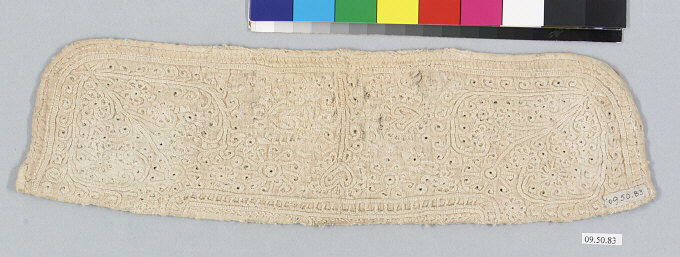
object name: cap fragment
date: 1701-1900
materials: linen